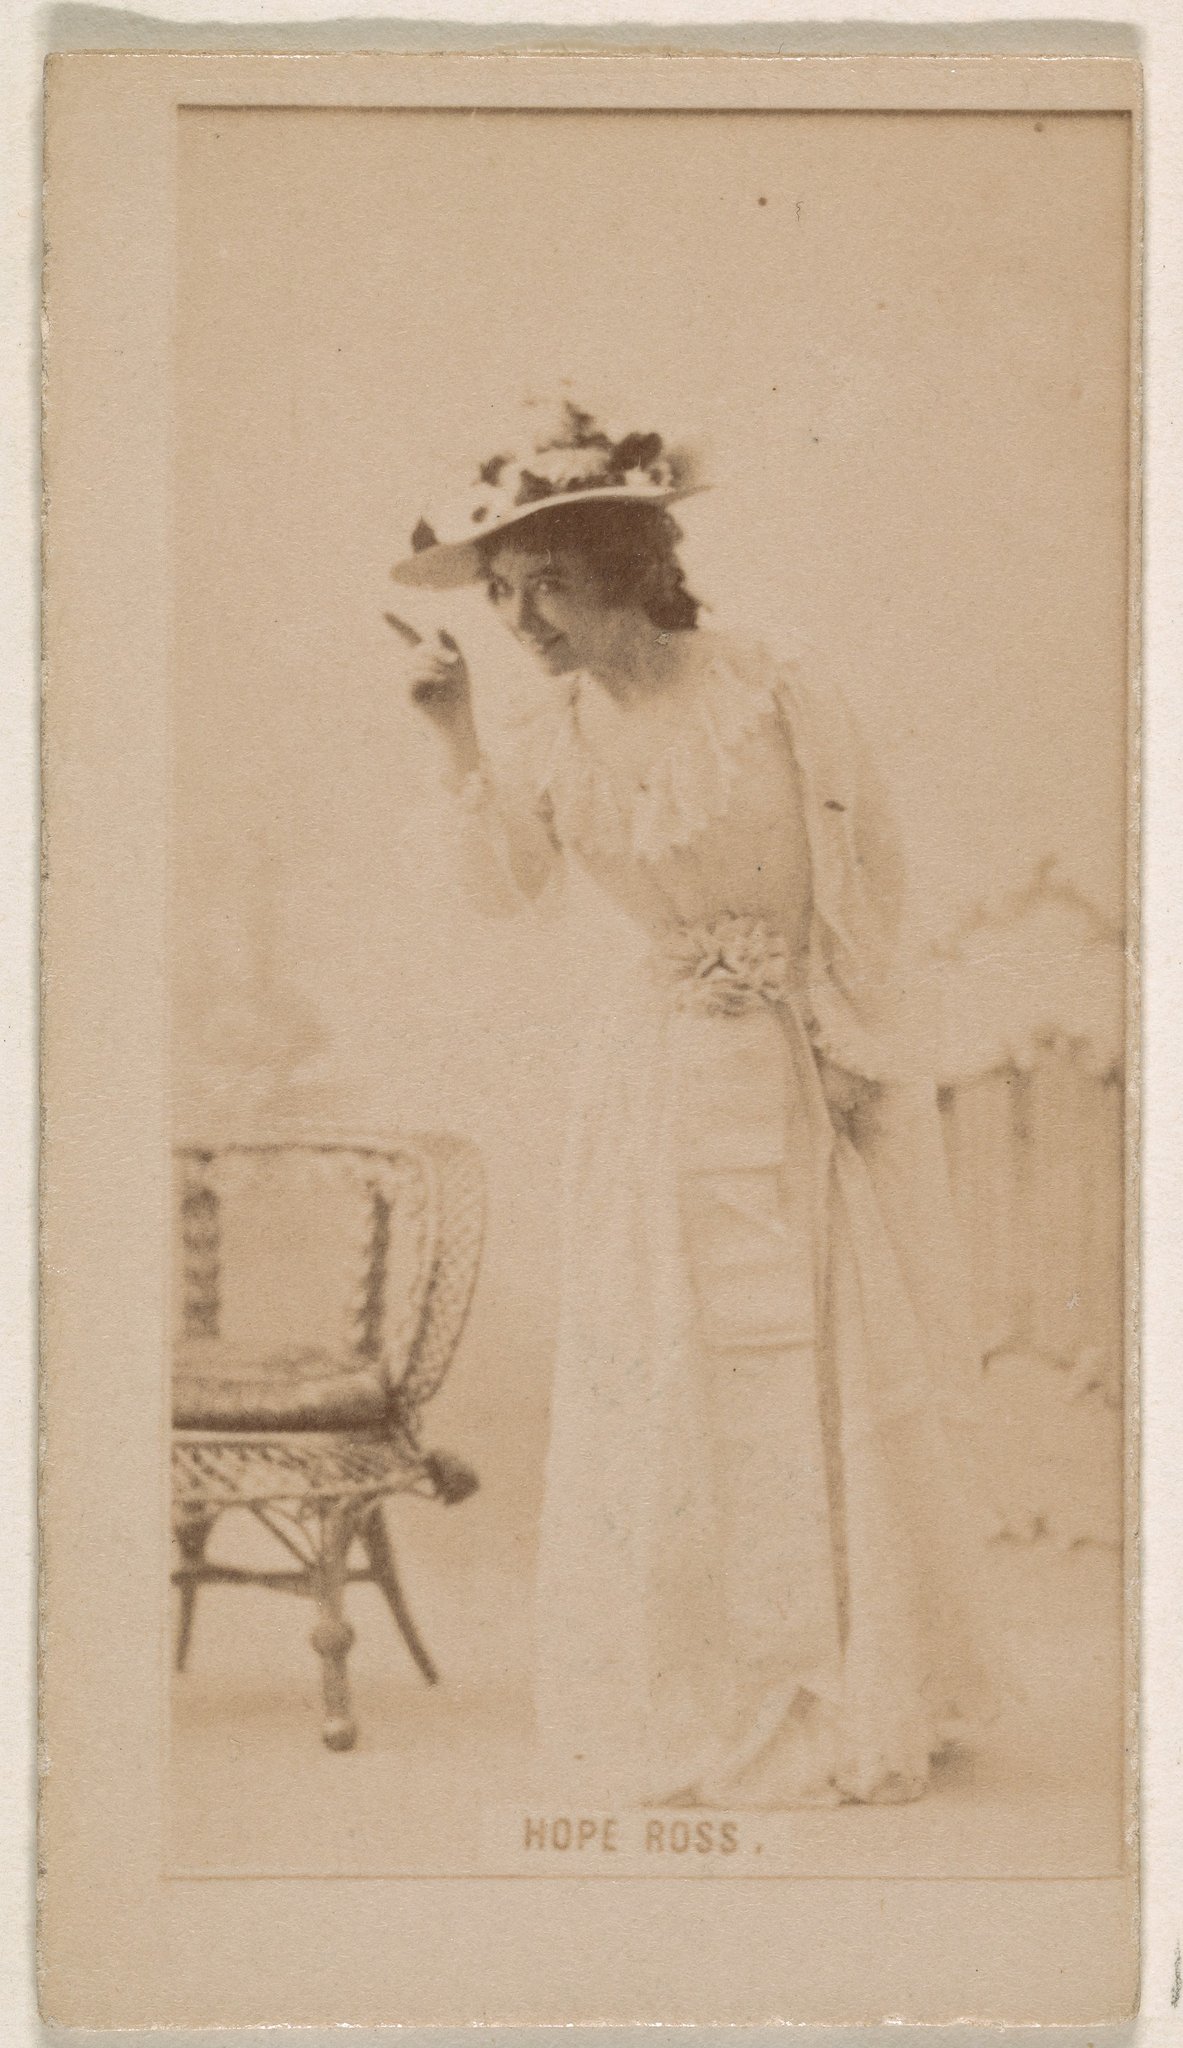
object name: photograph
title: Hope Ross, from the Actresses series (N245) issued by Kinney Brothers to promote Sweet Caporal Cigarettes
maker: kinney brothers tobacco company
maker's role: publisher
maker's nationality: american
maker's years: 1869-2011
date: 1890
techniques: albumen silver print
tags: portraits,women,actresses